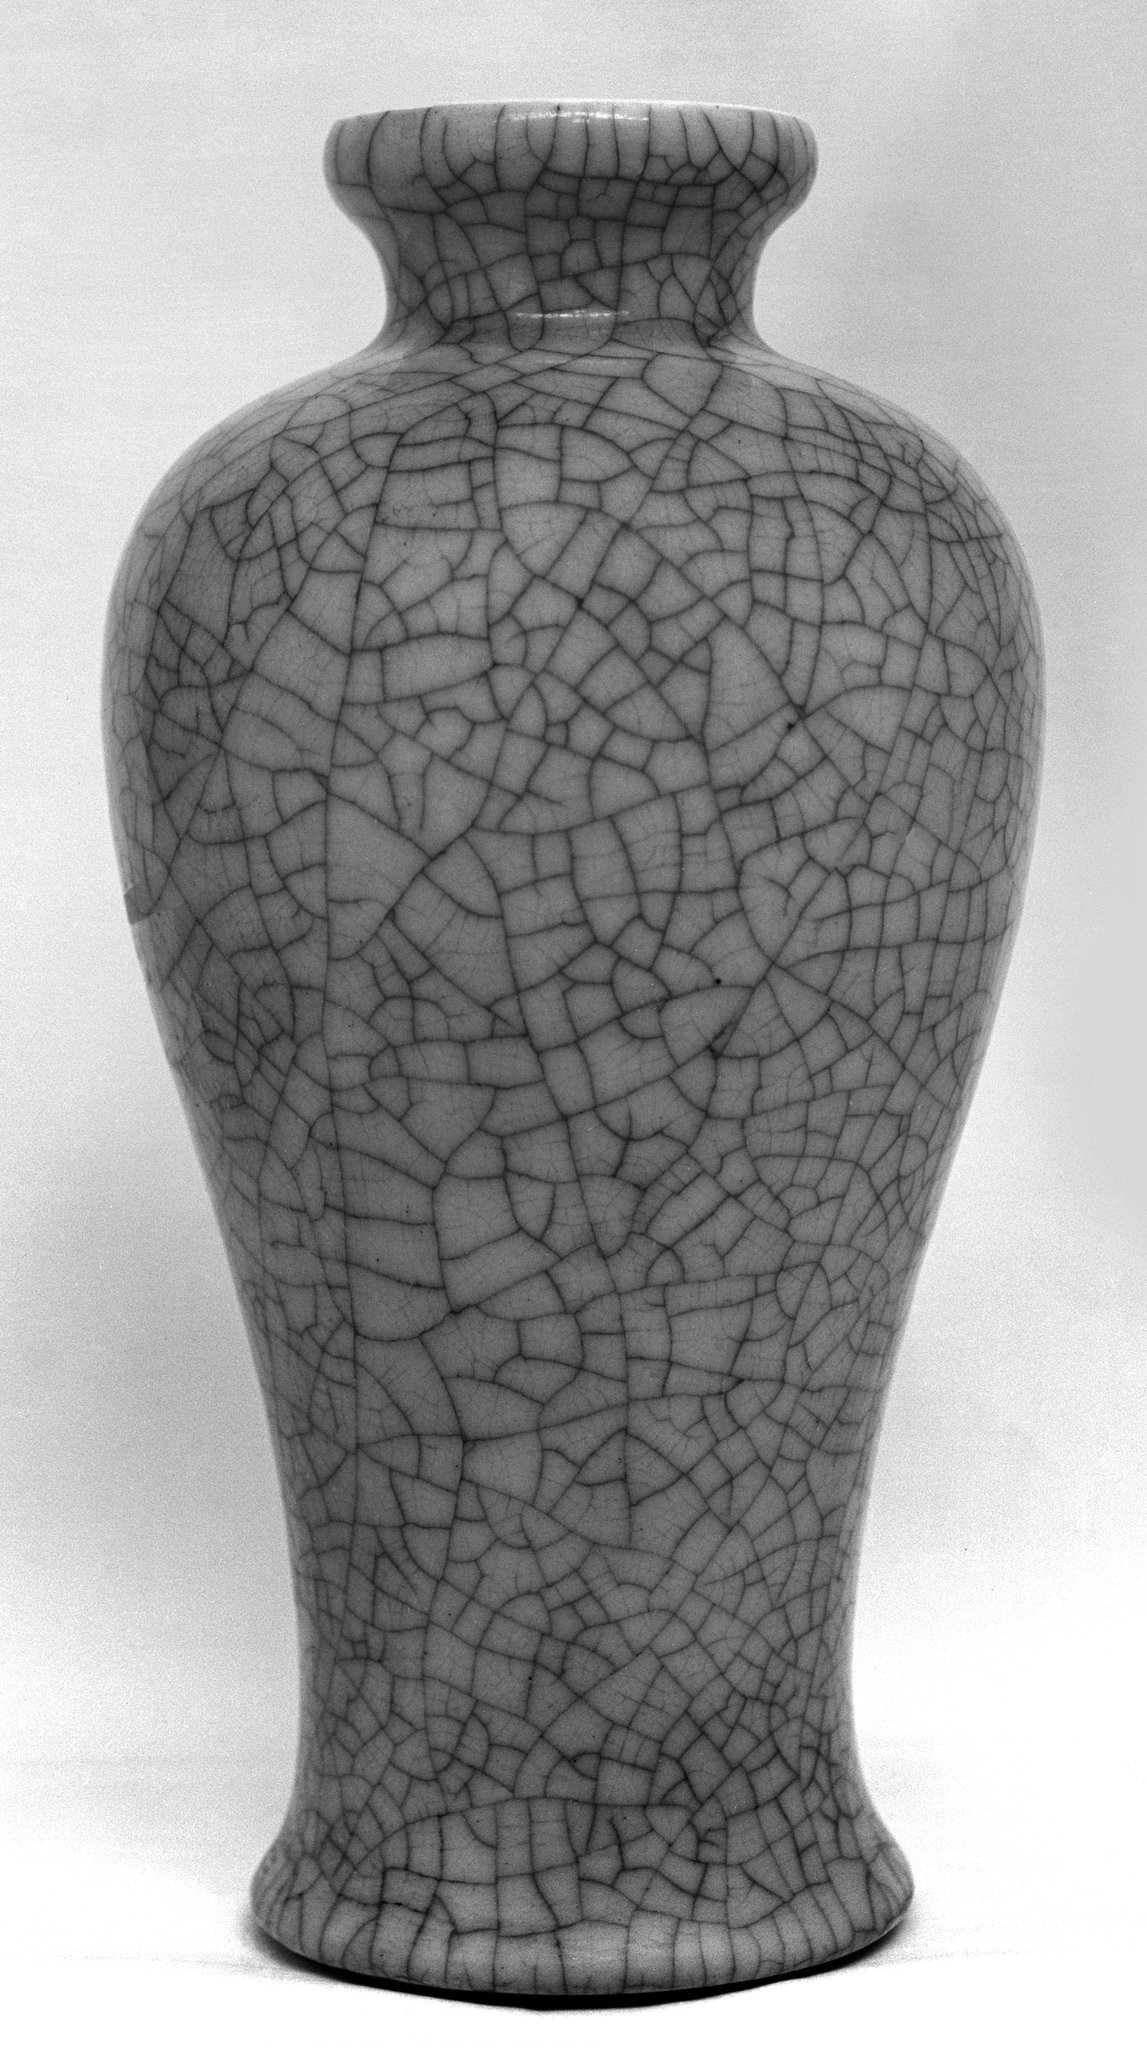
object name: vase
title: Meiping vase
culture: chinese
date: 1701-1733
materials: glaze, porcelain